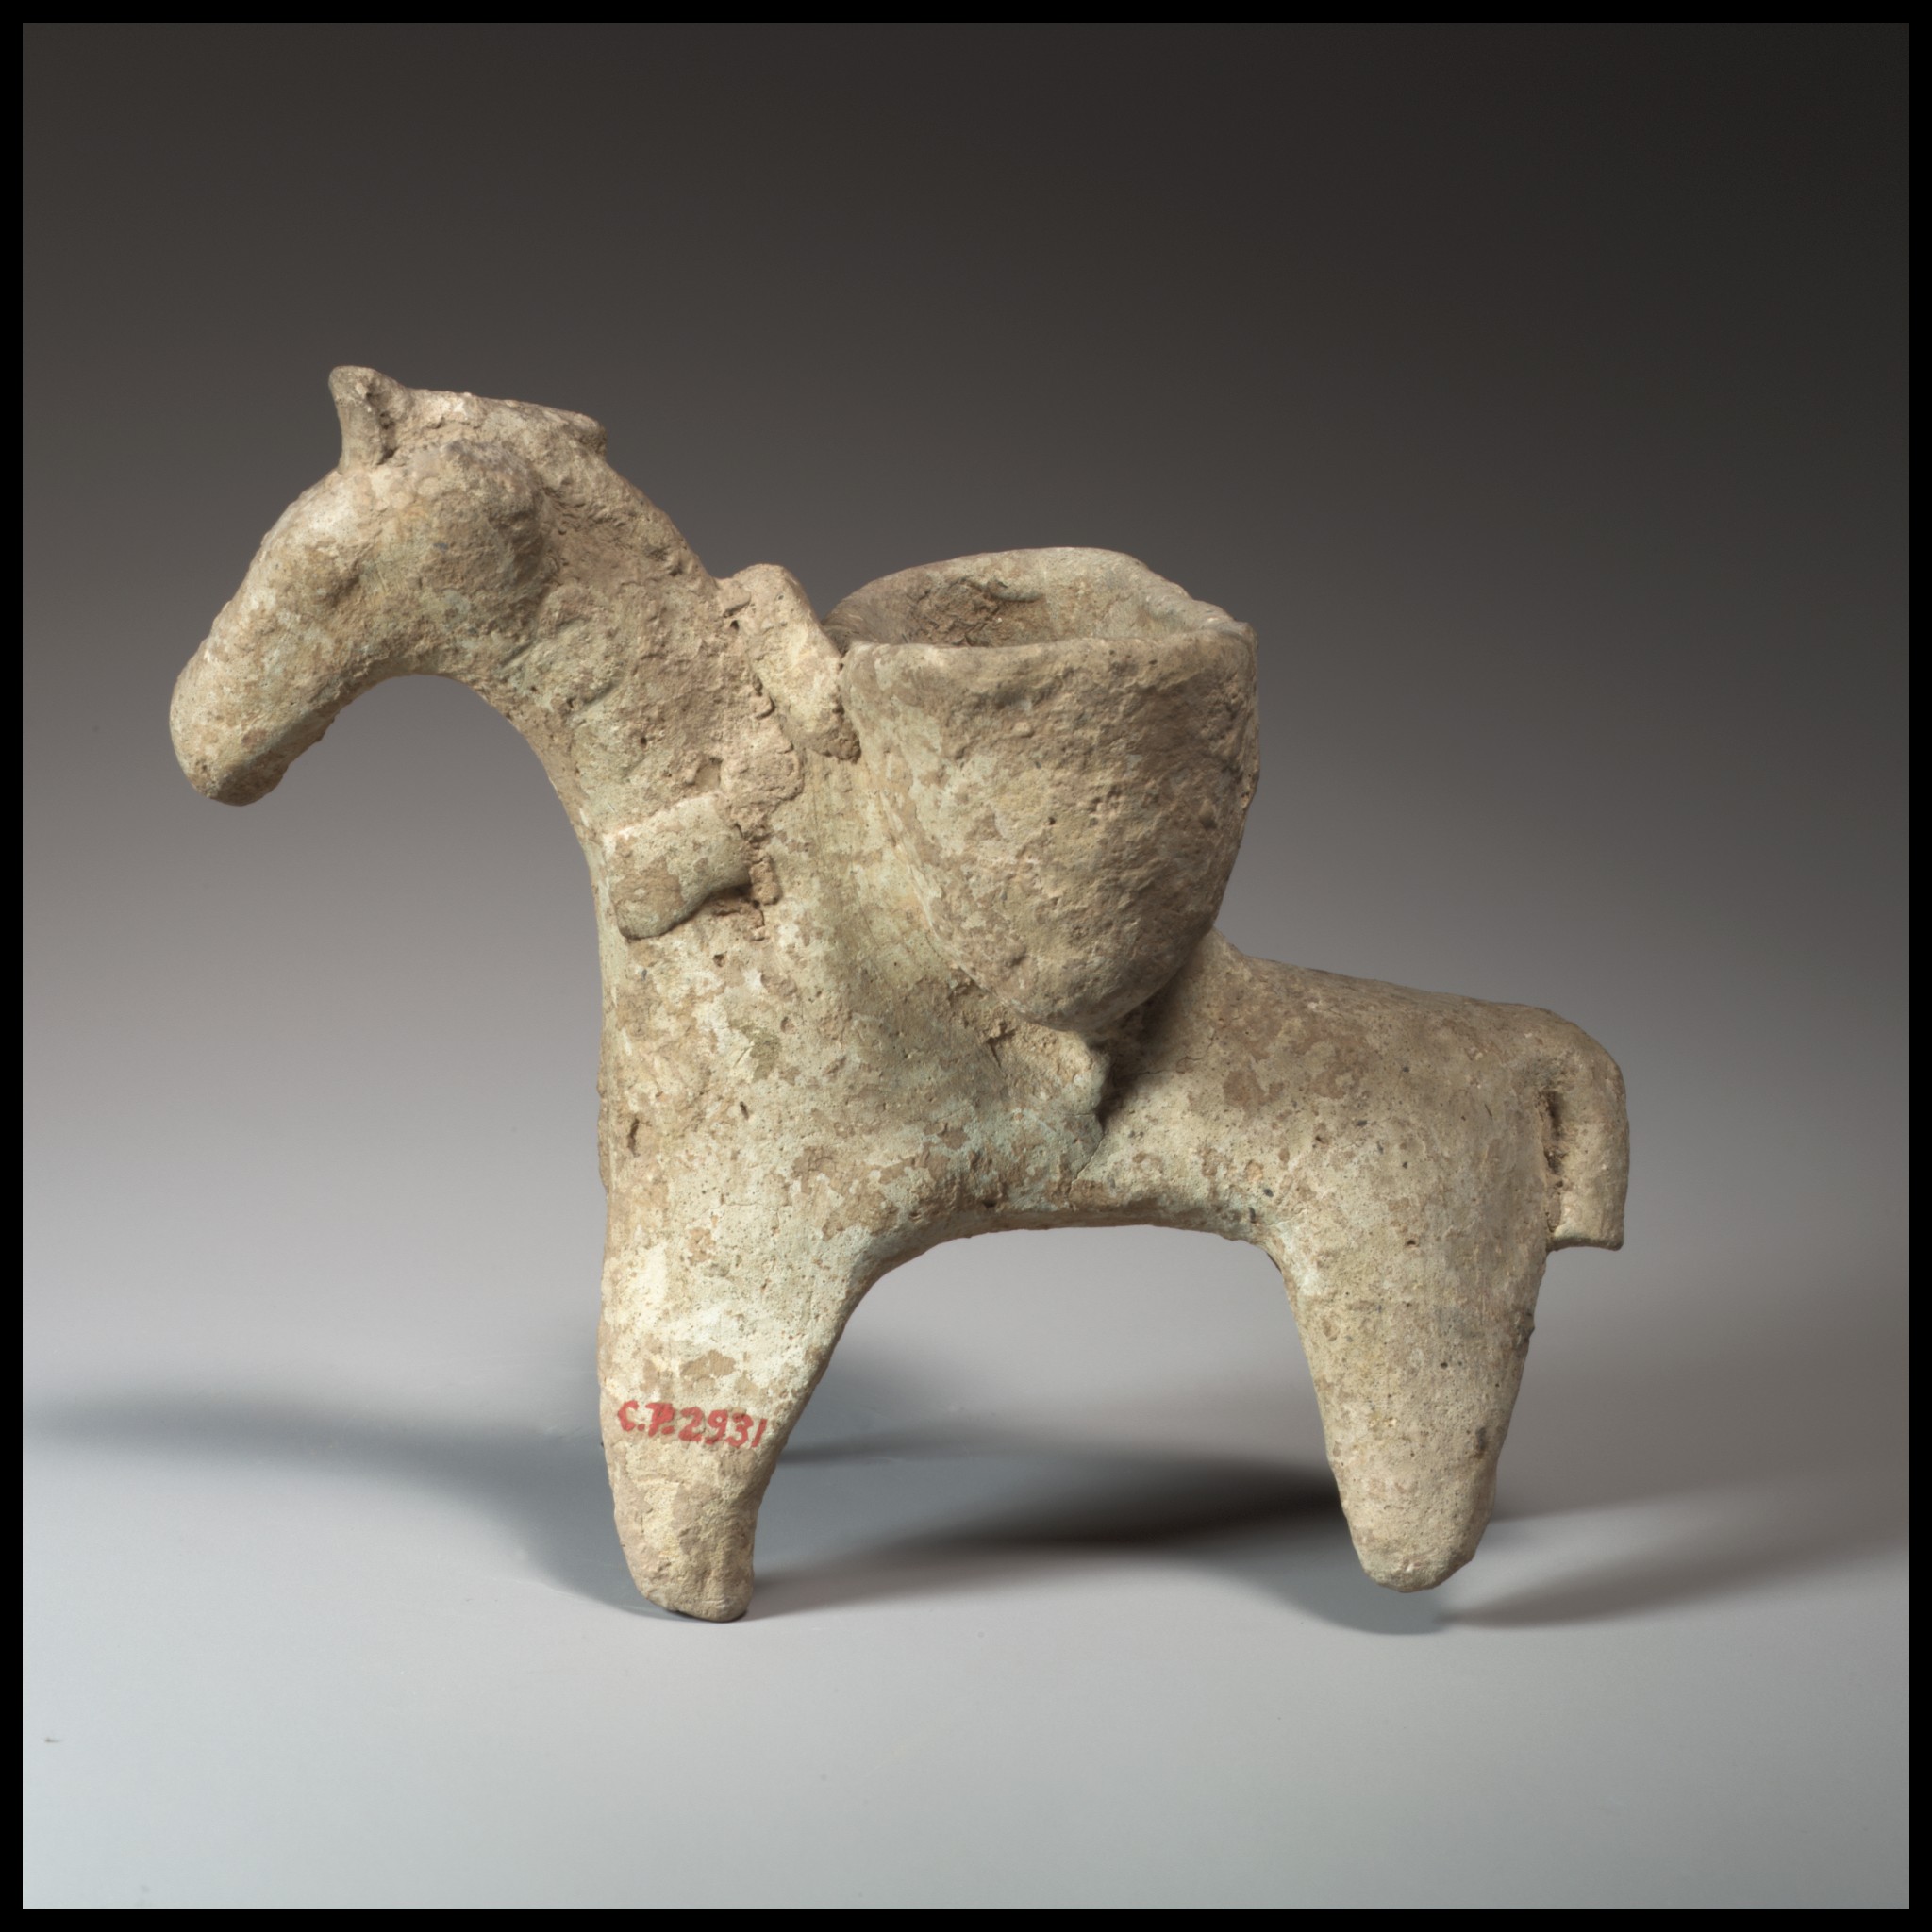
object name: statuette of an as with pannier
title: Donkey figurine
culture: cypriot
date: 600-480 BCE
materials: terracotta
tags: donkeys